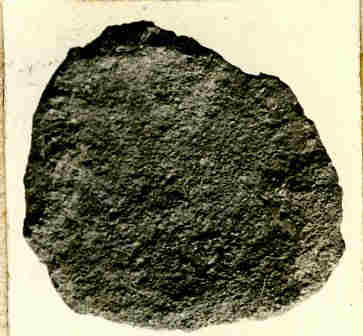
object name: coin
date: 758-768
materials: copper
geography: iran